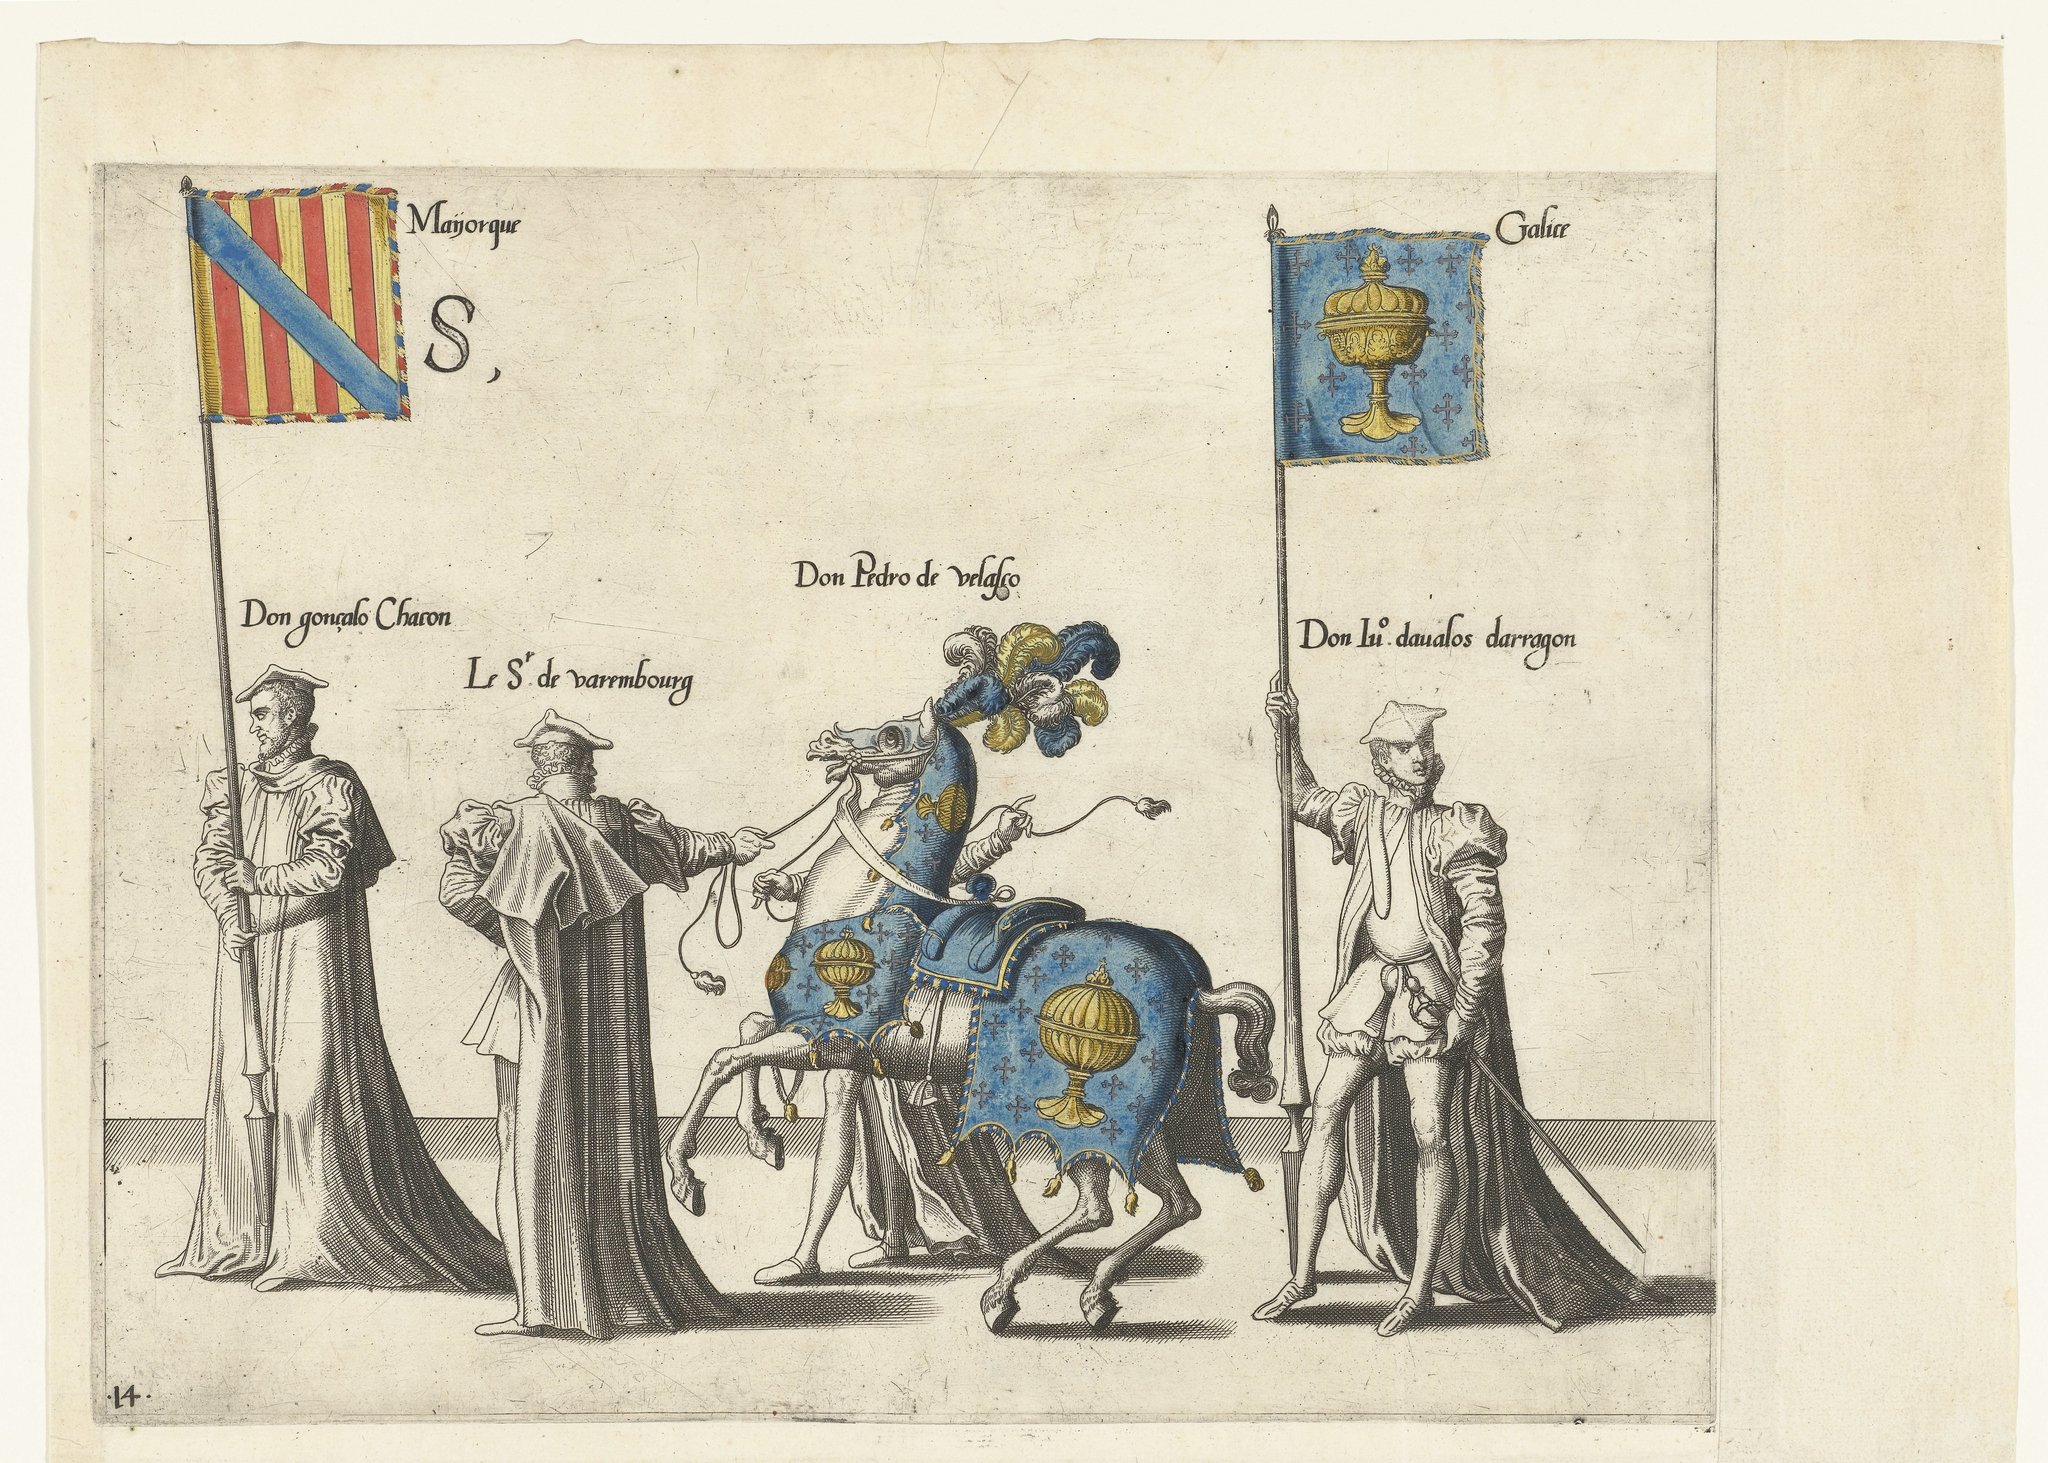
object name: print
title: Deel van de optocht, nr. 14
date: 1559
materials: paper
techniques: engraving, etching, hand coloring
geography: southern netherlands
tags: ghent, charles v (holy roman emperor and king of spain), cortege, funeral procession, brussels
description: Vier deelnemers aan de optocht, paarden en de vaandels met de wapens van Mallorca en Galicië. Onderdeel van de prentreeks van de Begrafenisoptocht van keizer Karel V op 29 december 1558 te Brussel.